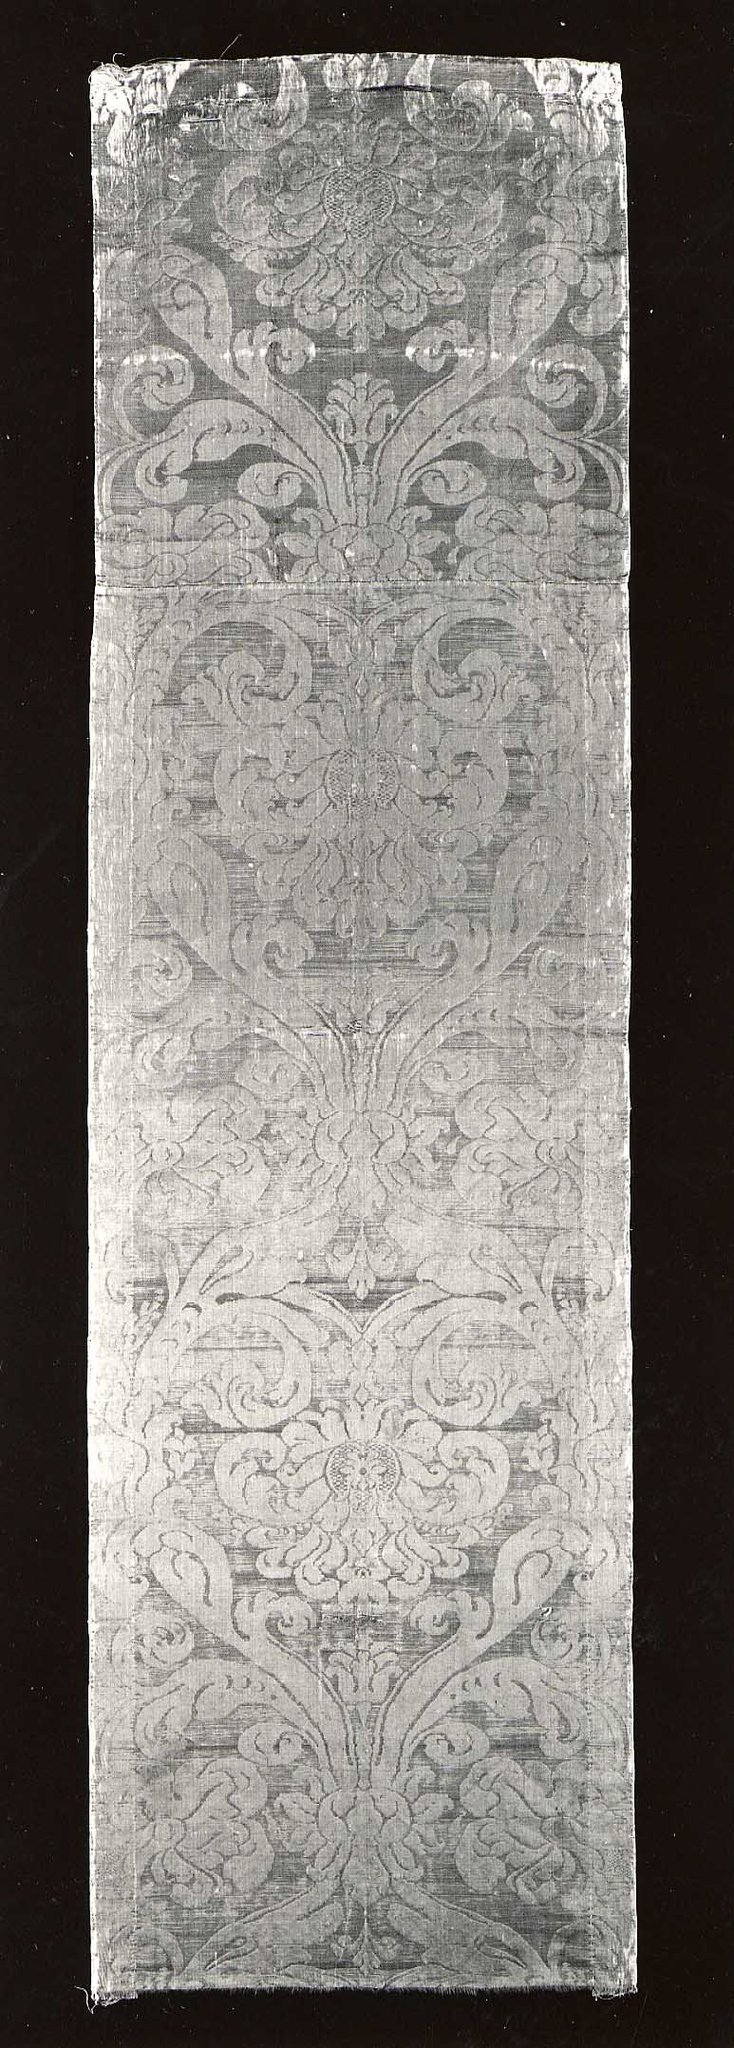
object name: textile panel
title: Panel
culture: italian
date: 1651-1700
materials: hemp, linen, silk